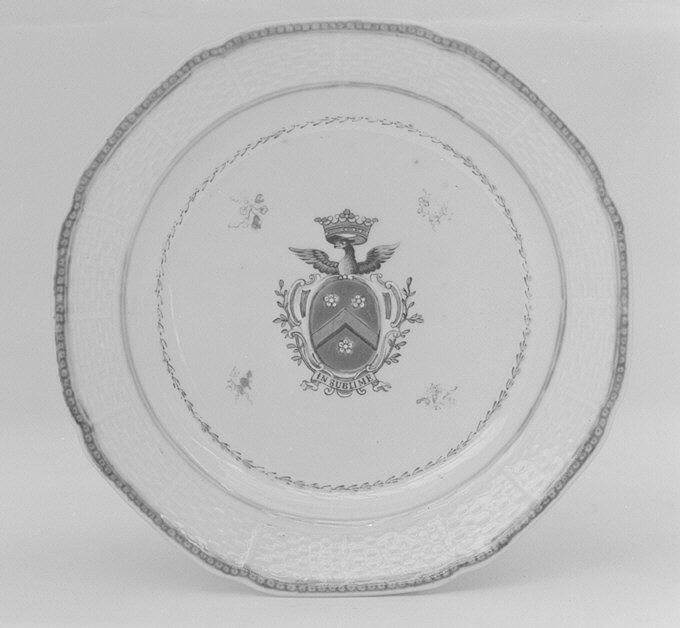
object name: plate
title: Plate (part of a service)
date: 1770-1785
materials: hard paste porcelain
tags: eagles,coat of arms